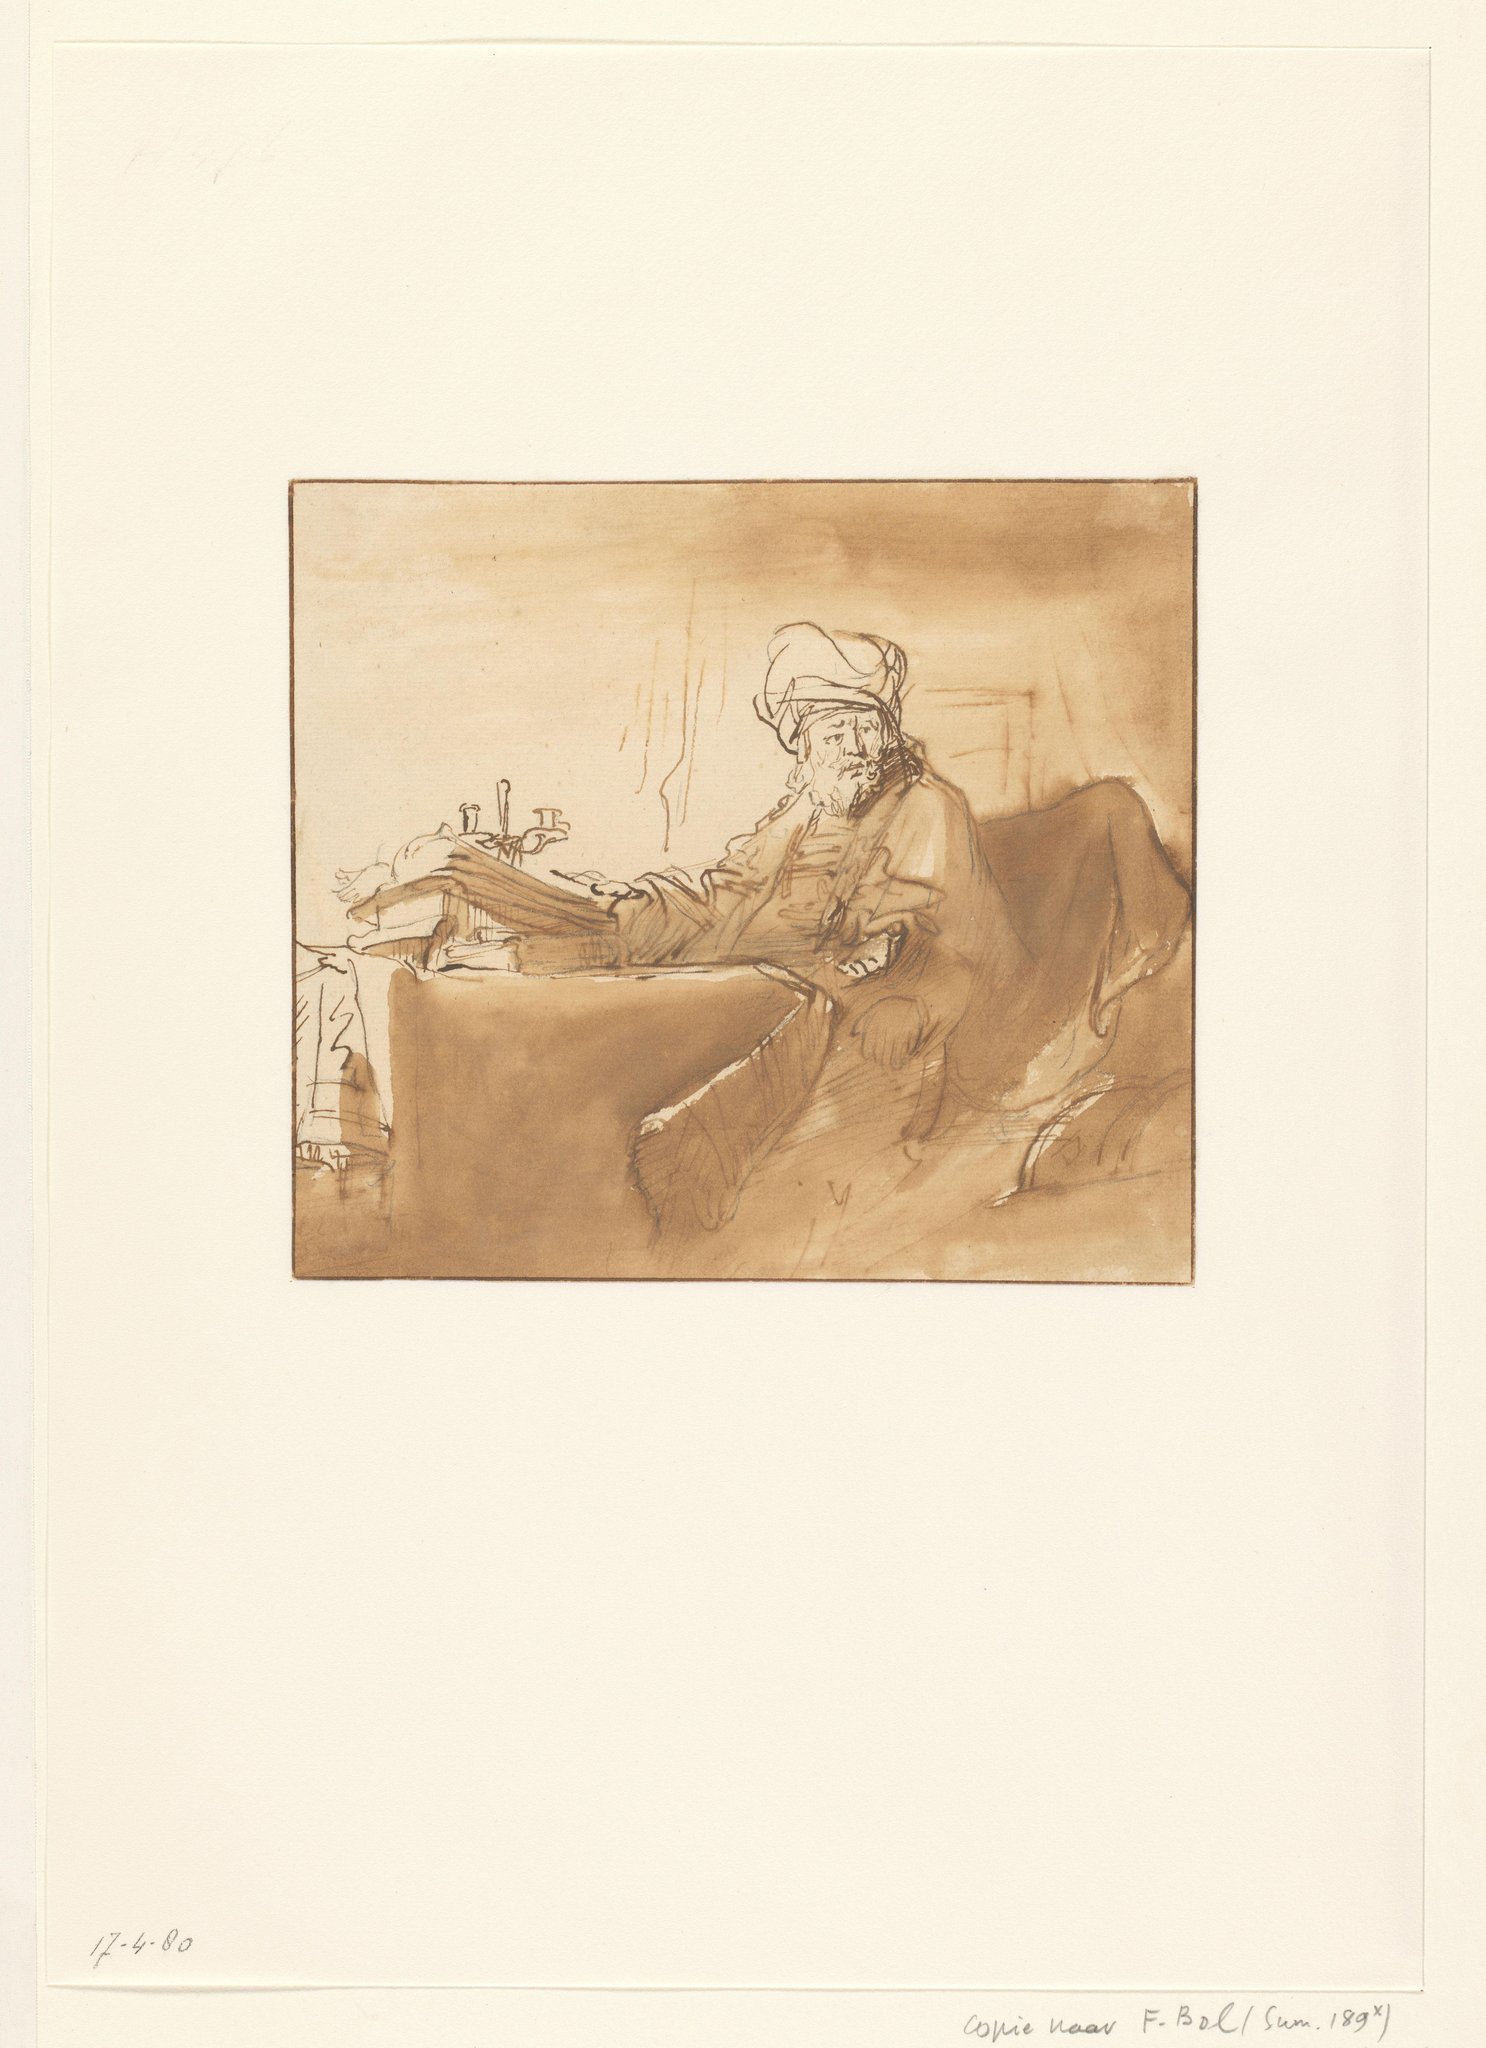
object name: drawing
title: Oosterse geleerde aan een tafel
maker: salomon koninck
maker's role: draughtsman, painter, print maker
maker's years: 1609-1656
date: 1641-1656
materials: chalk, ink, paper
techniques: brush, pen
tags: scholar in his study, book - mm - book open, head-gear: turban